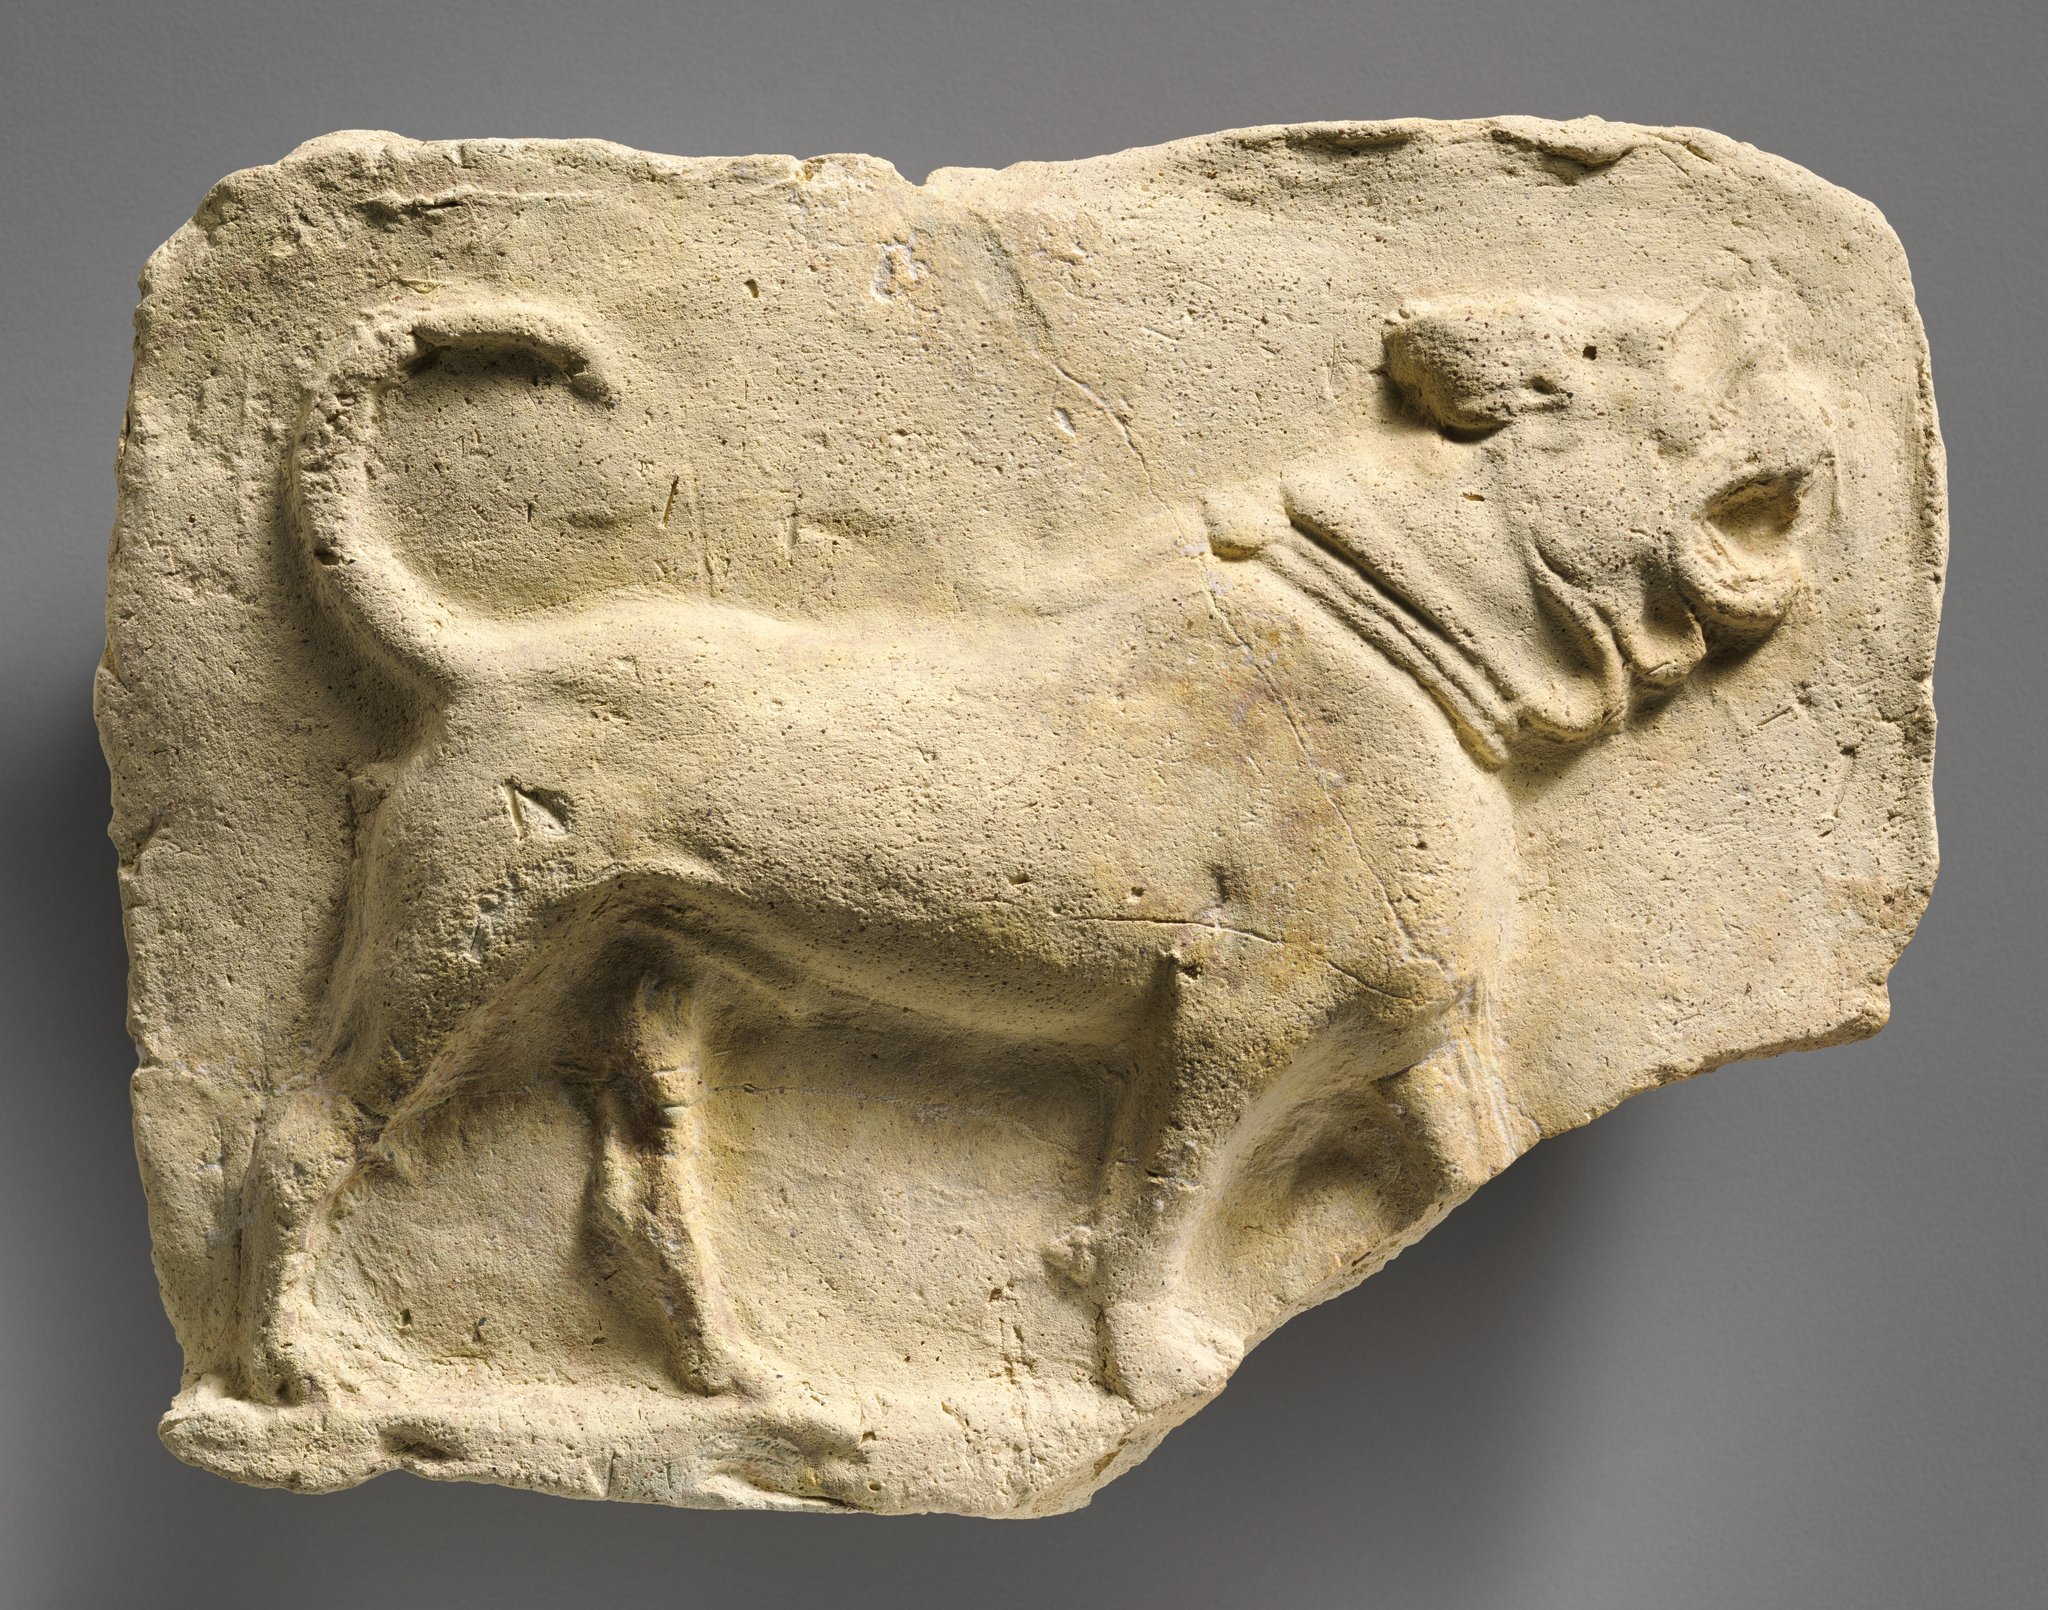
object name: relief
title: Molded plaque: mastiff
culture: babylonian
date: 2000-1600 BCE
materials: ceramic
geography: southern mesopotamia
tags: dogs